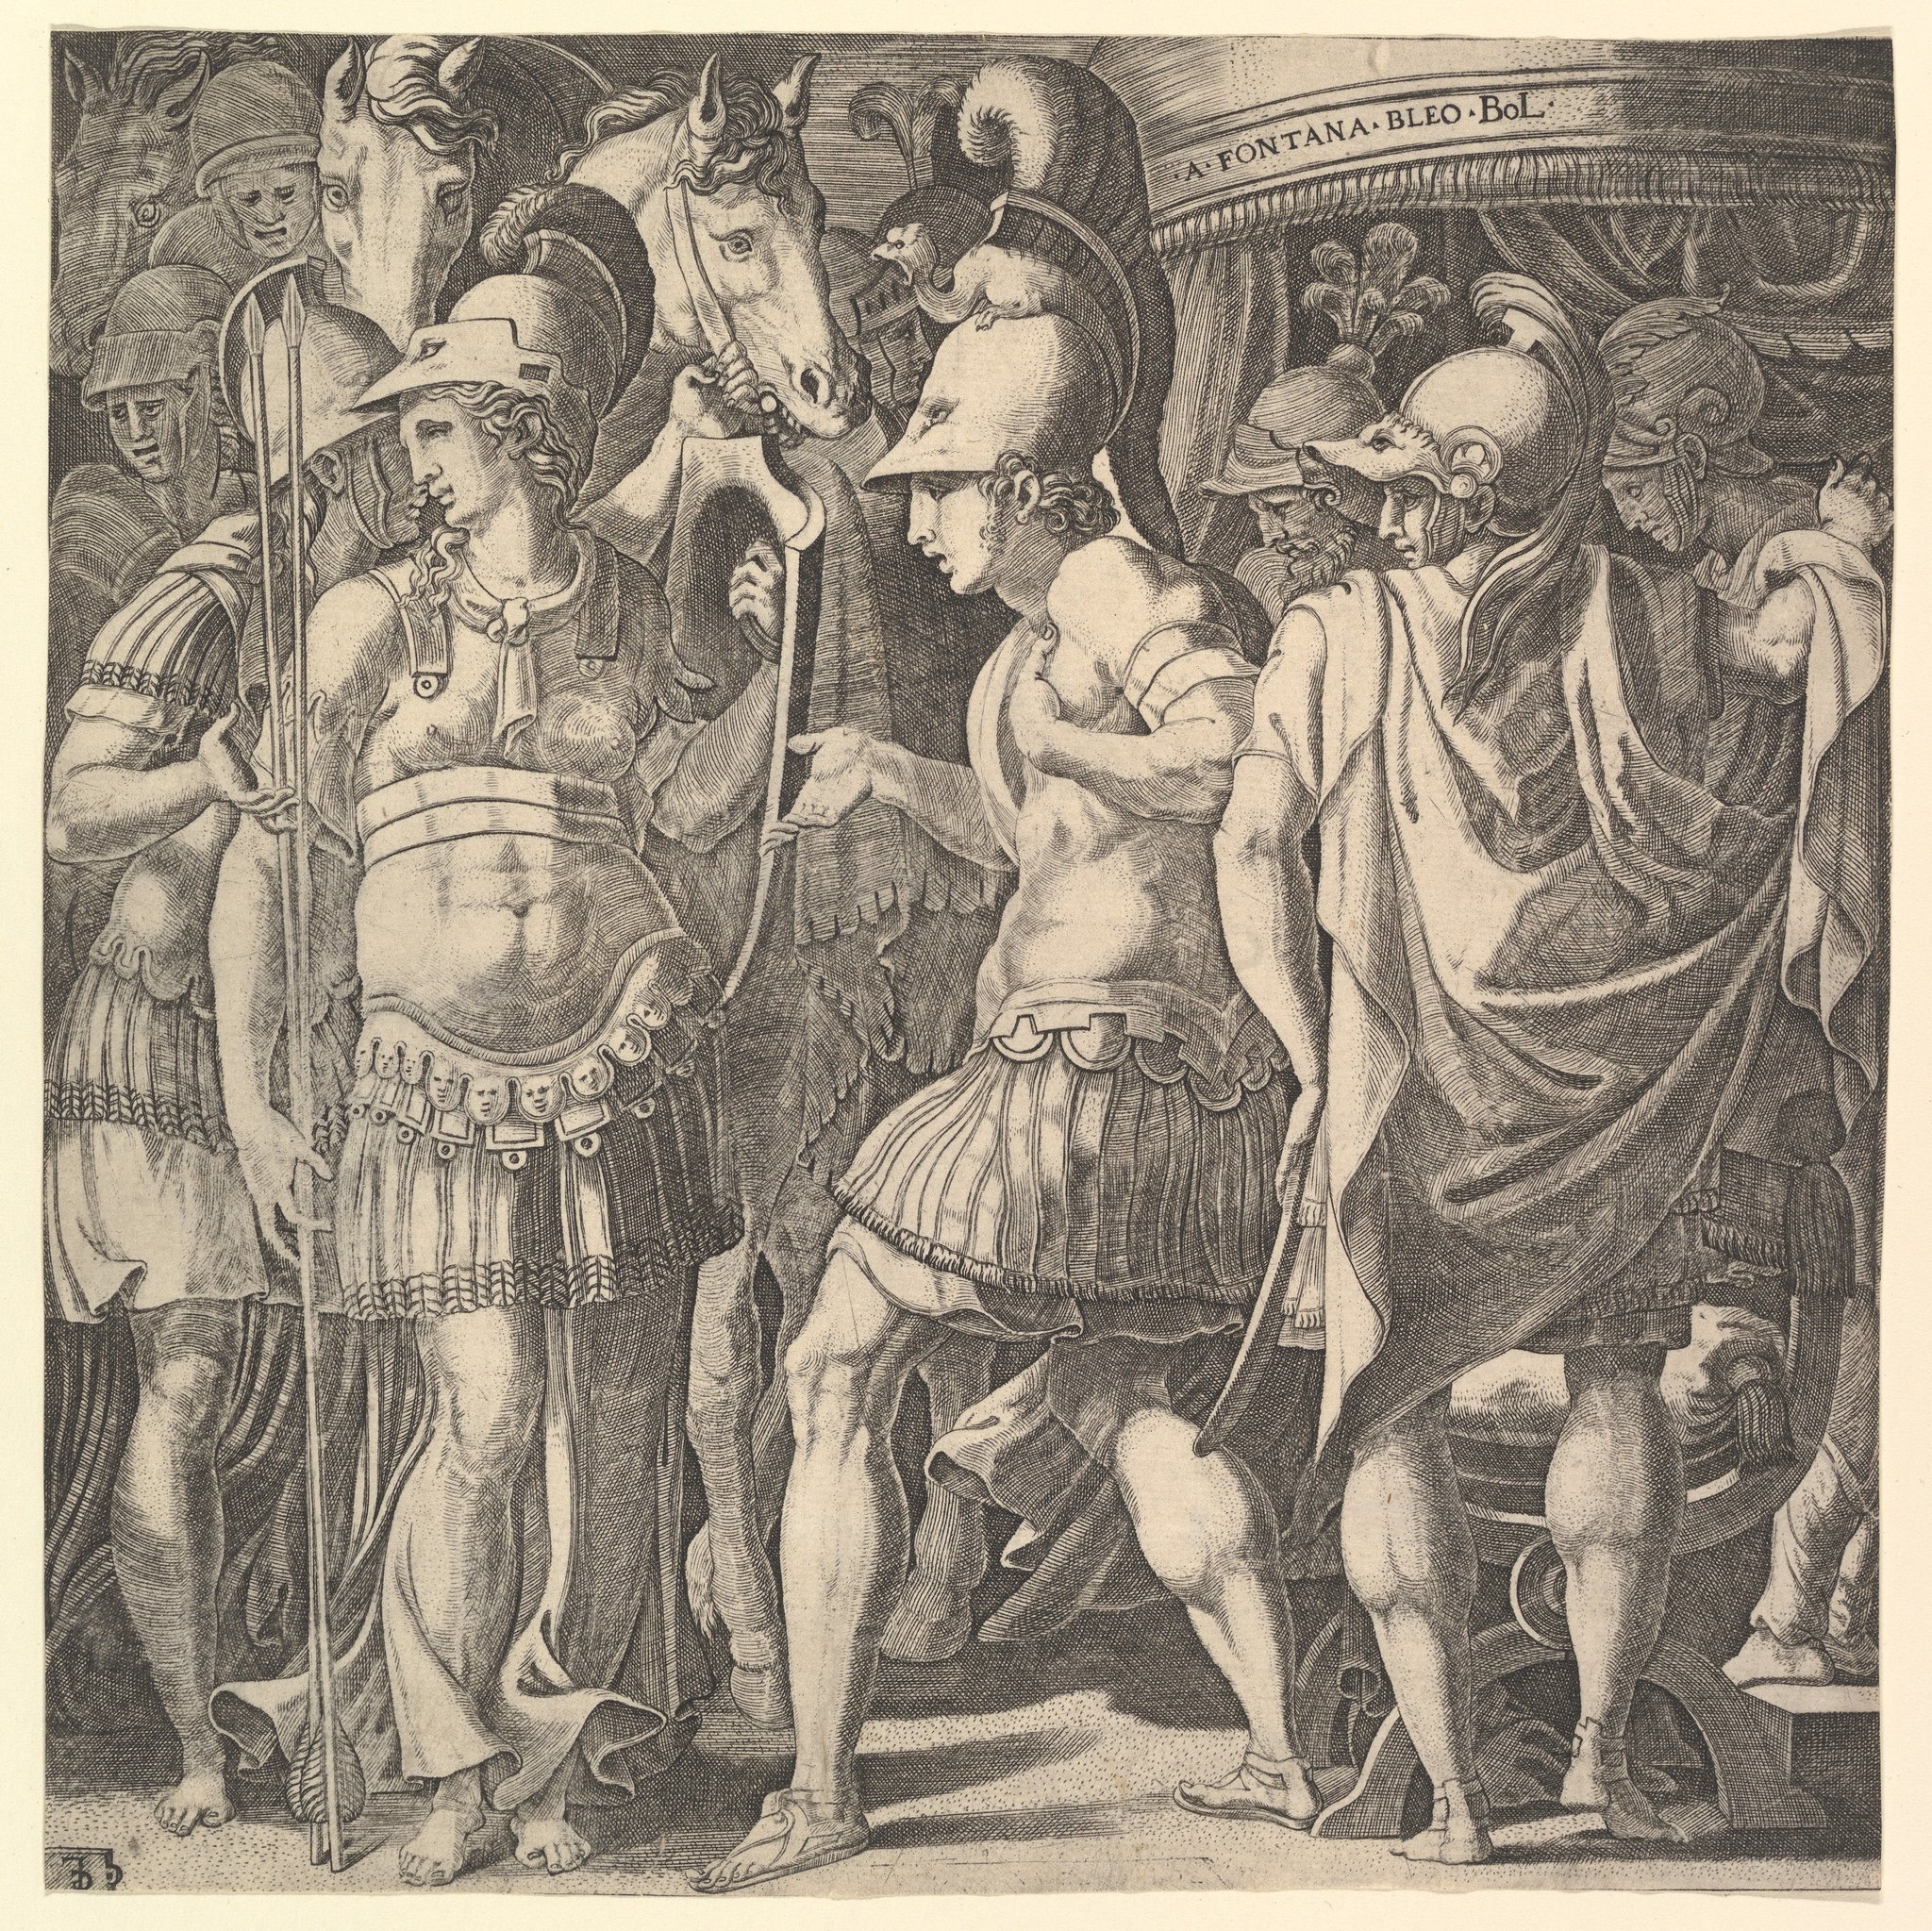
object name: print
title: Alexander welcoming Thalestris and the Amazons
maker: master fg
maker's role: artist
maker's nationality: italian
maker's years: 1530-1560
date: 1534-1566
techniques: engraving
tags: spears,alexander the great,amazons,horses